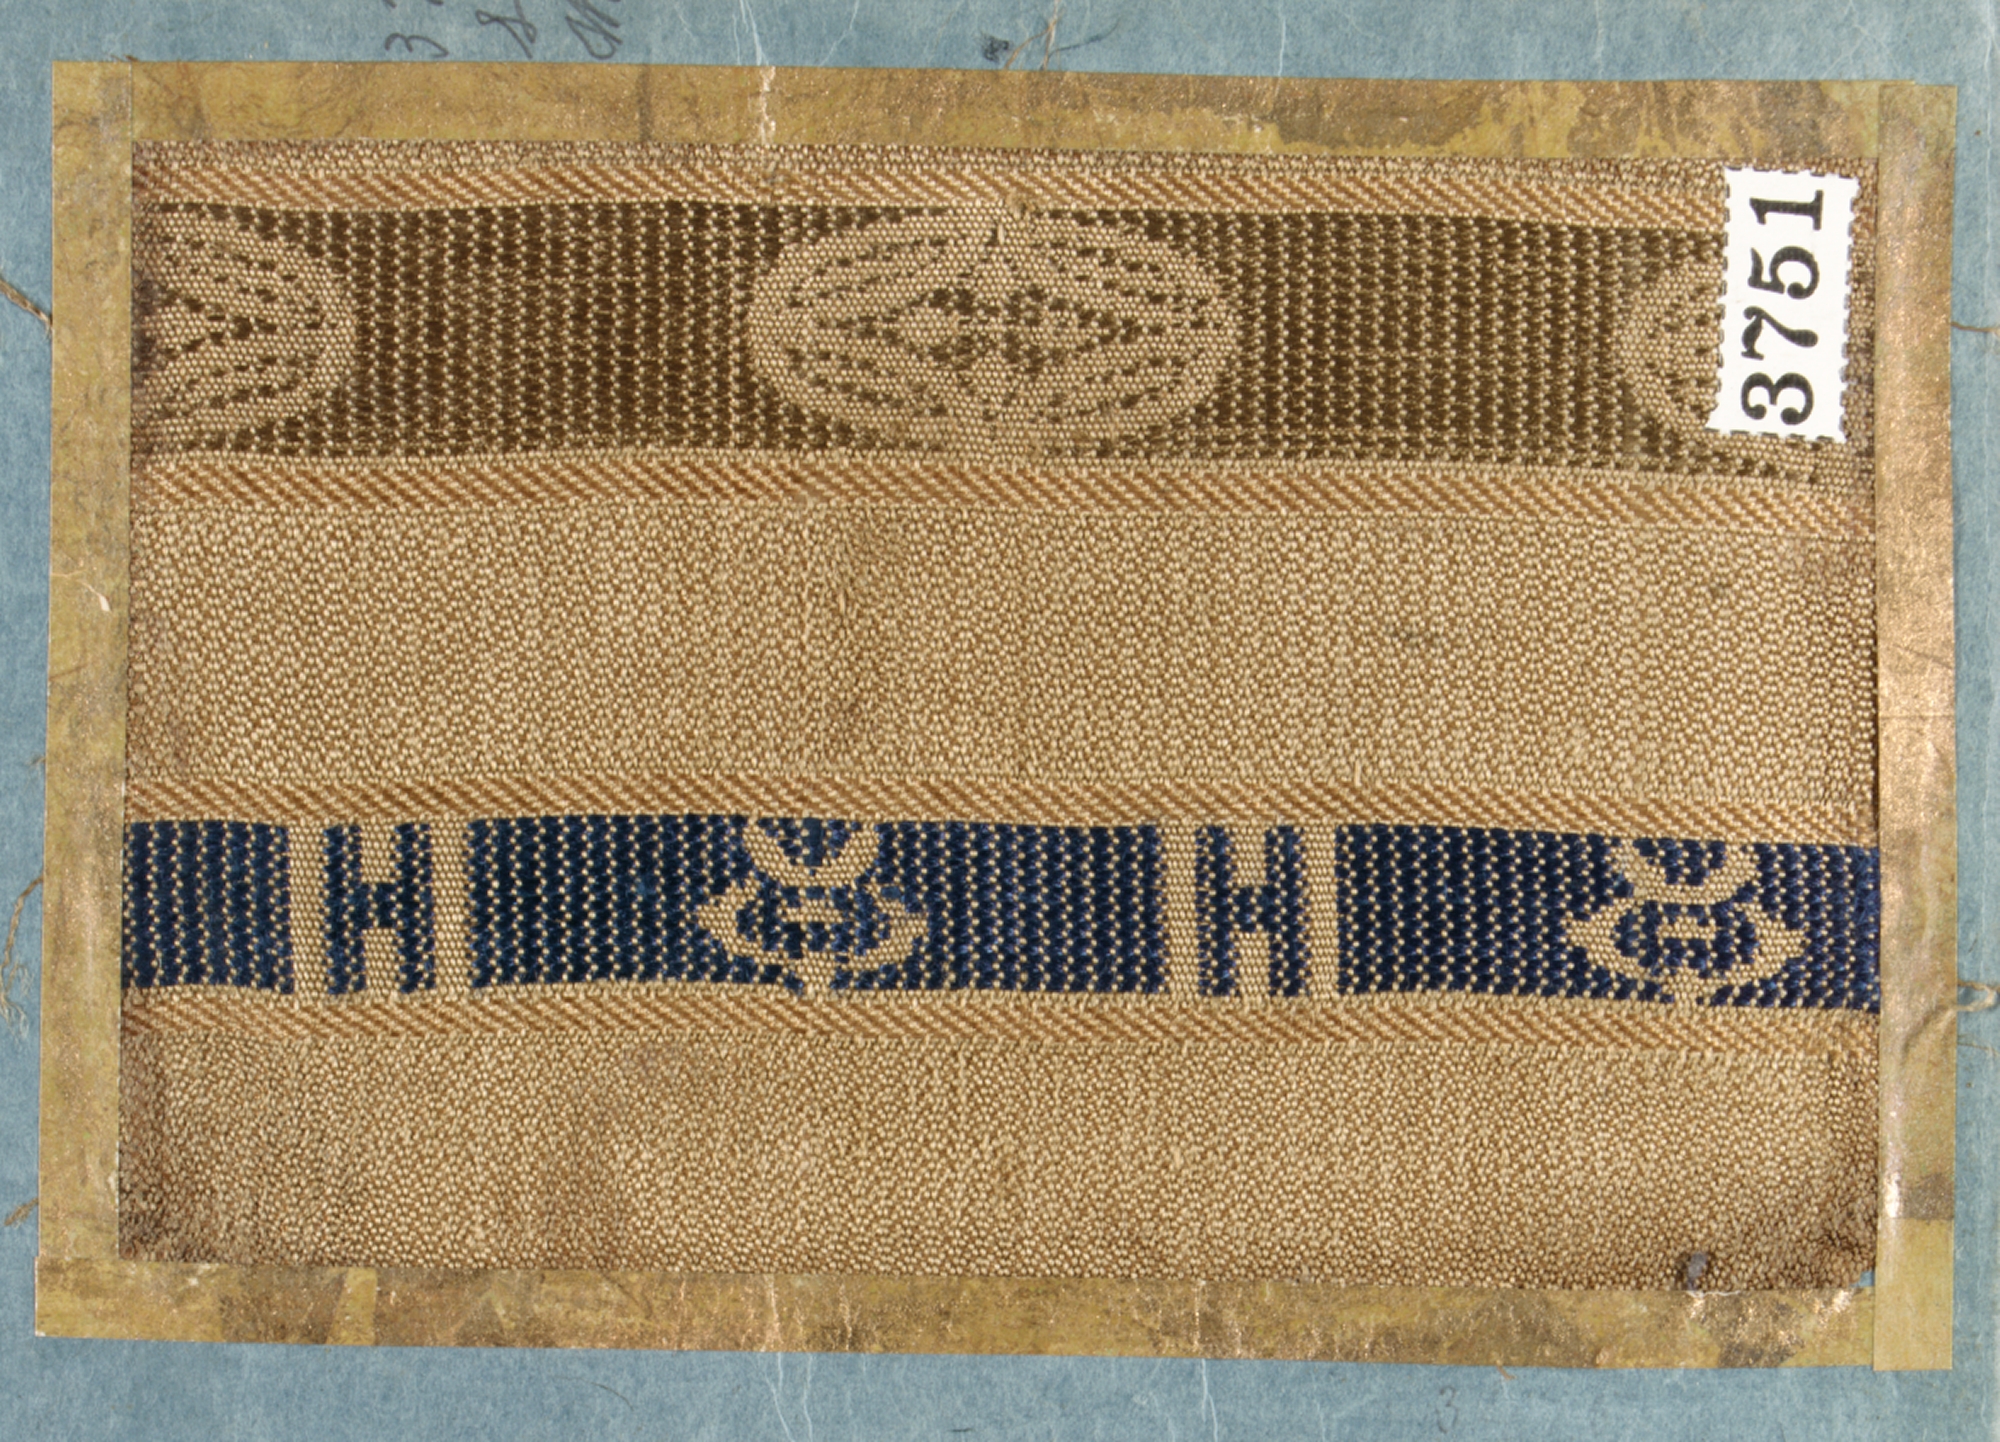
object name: sample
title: Textile Sample from Sample Book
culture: japanese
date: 1801-1900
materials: silk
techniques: tapestry